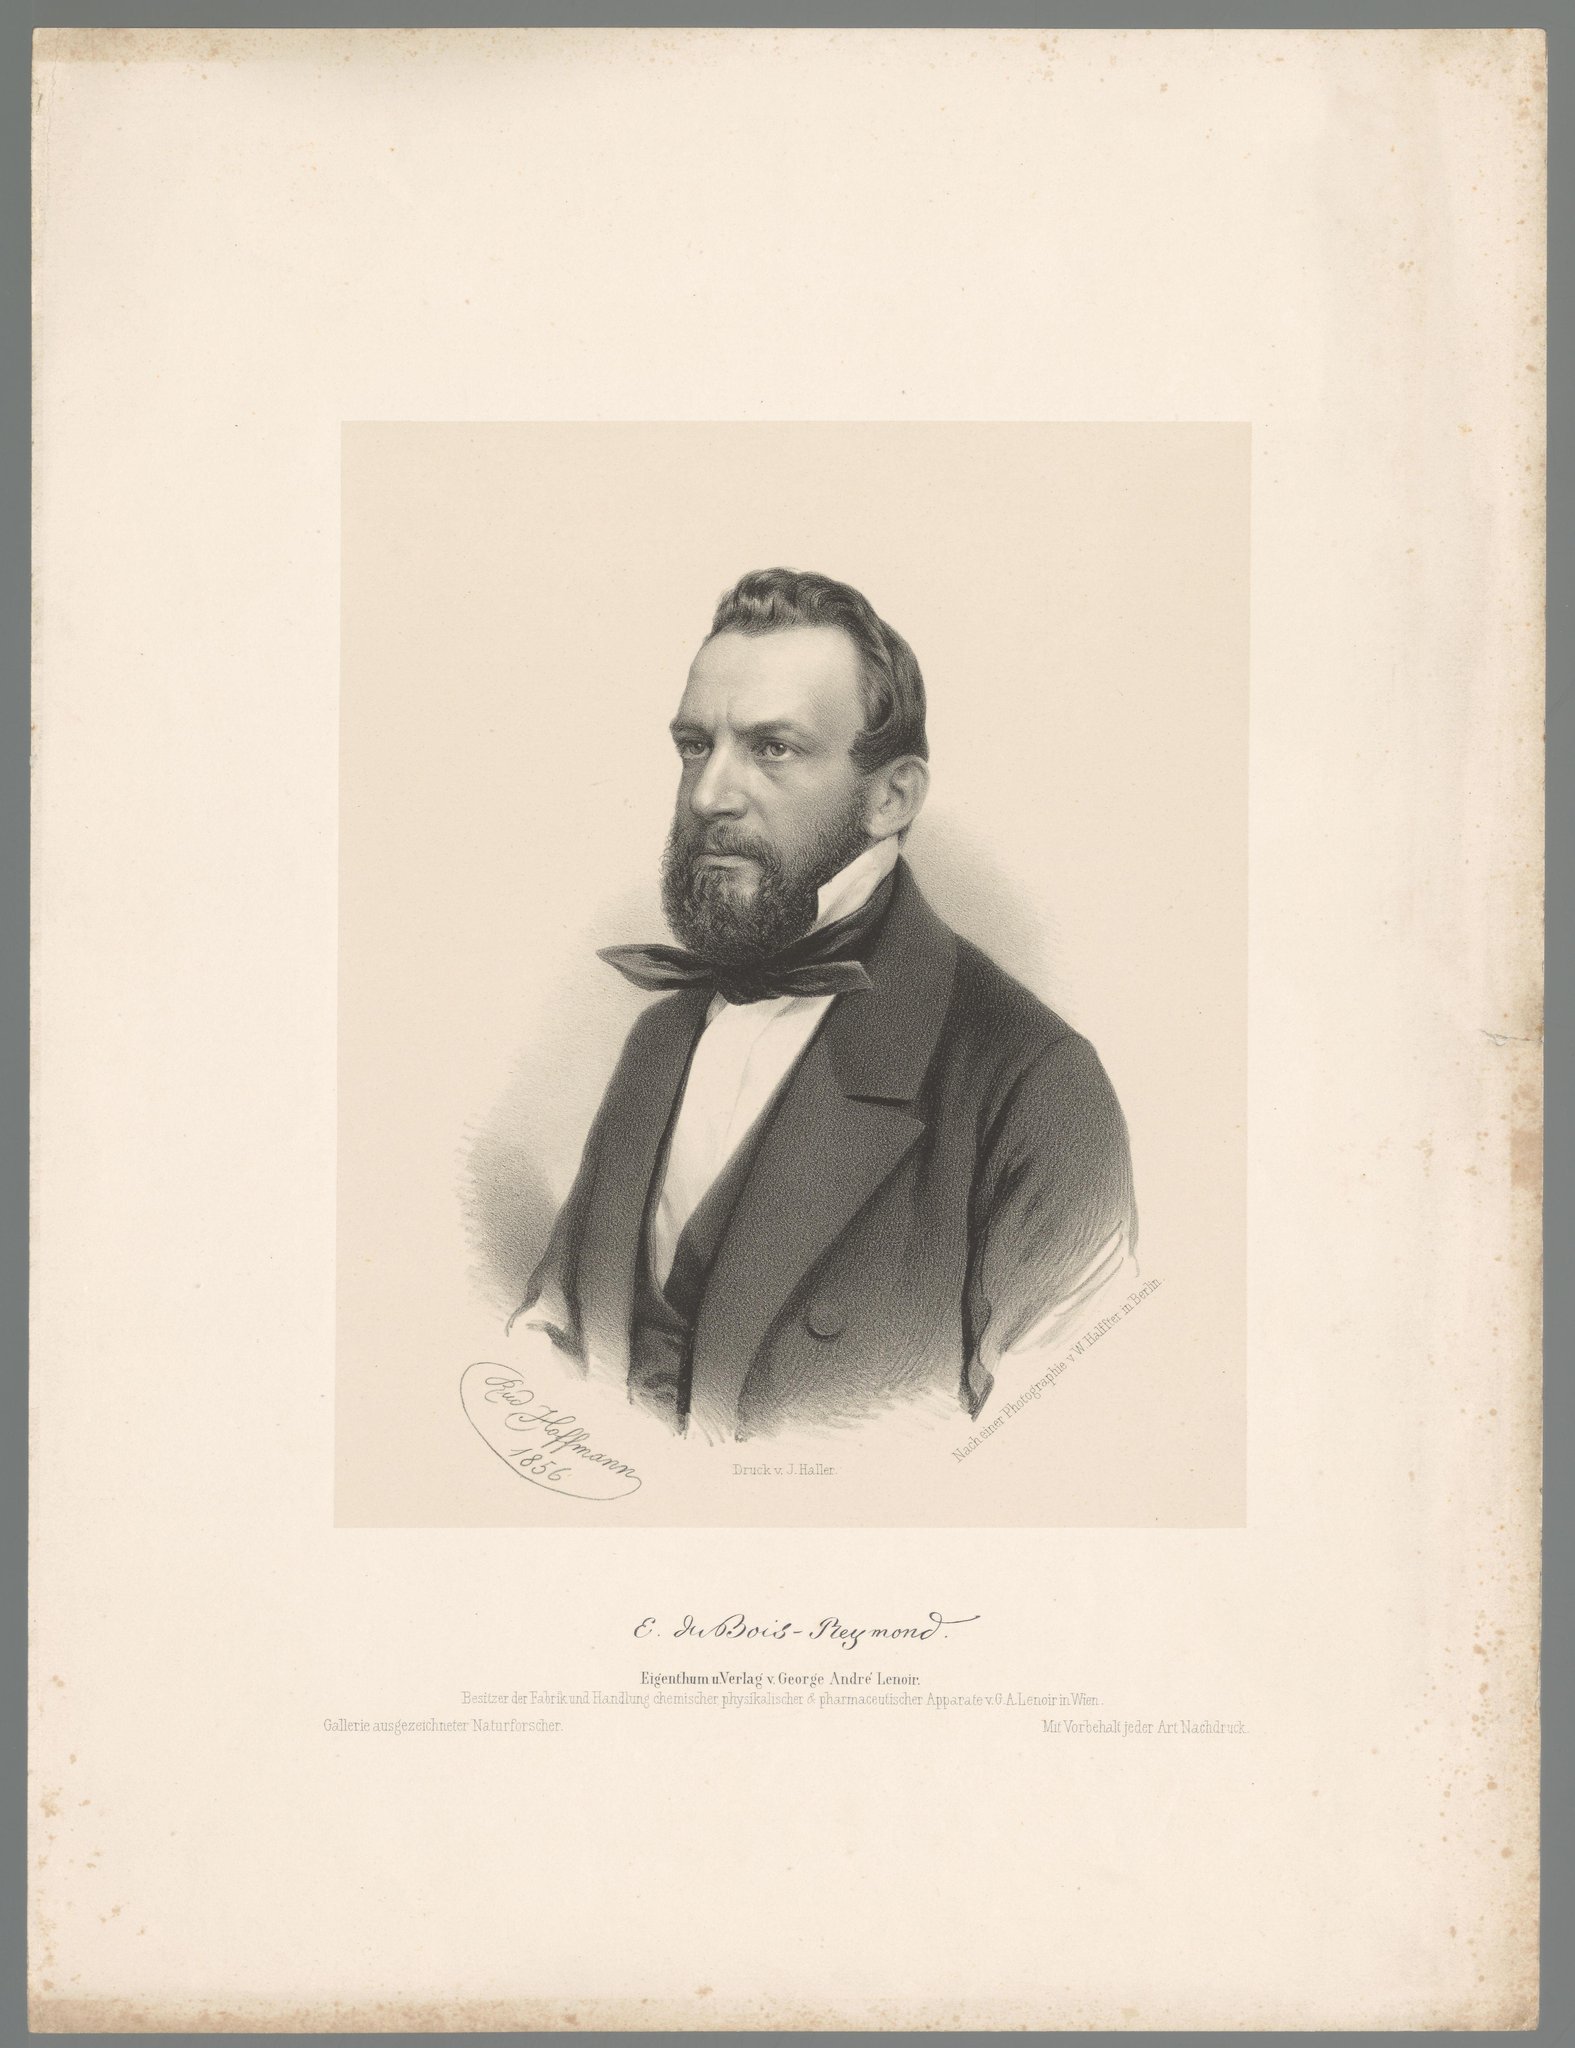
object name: print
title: Gallerie ausgezeichneter Naturforscher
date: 1856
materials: paper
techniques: lithograph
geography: vienna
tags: adult man, historical persons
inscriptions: collector's mark: Lugt 2228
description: Deze prent behoort tot een serie met 100 portretten van natuurwetenschappers, uitgegeven tussen 1856-1860.